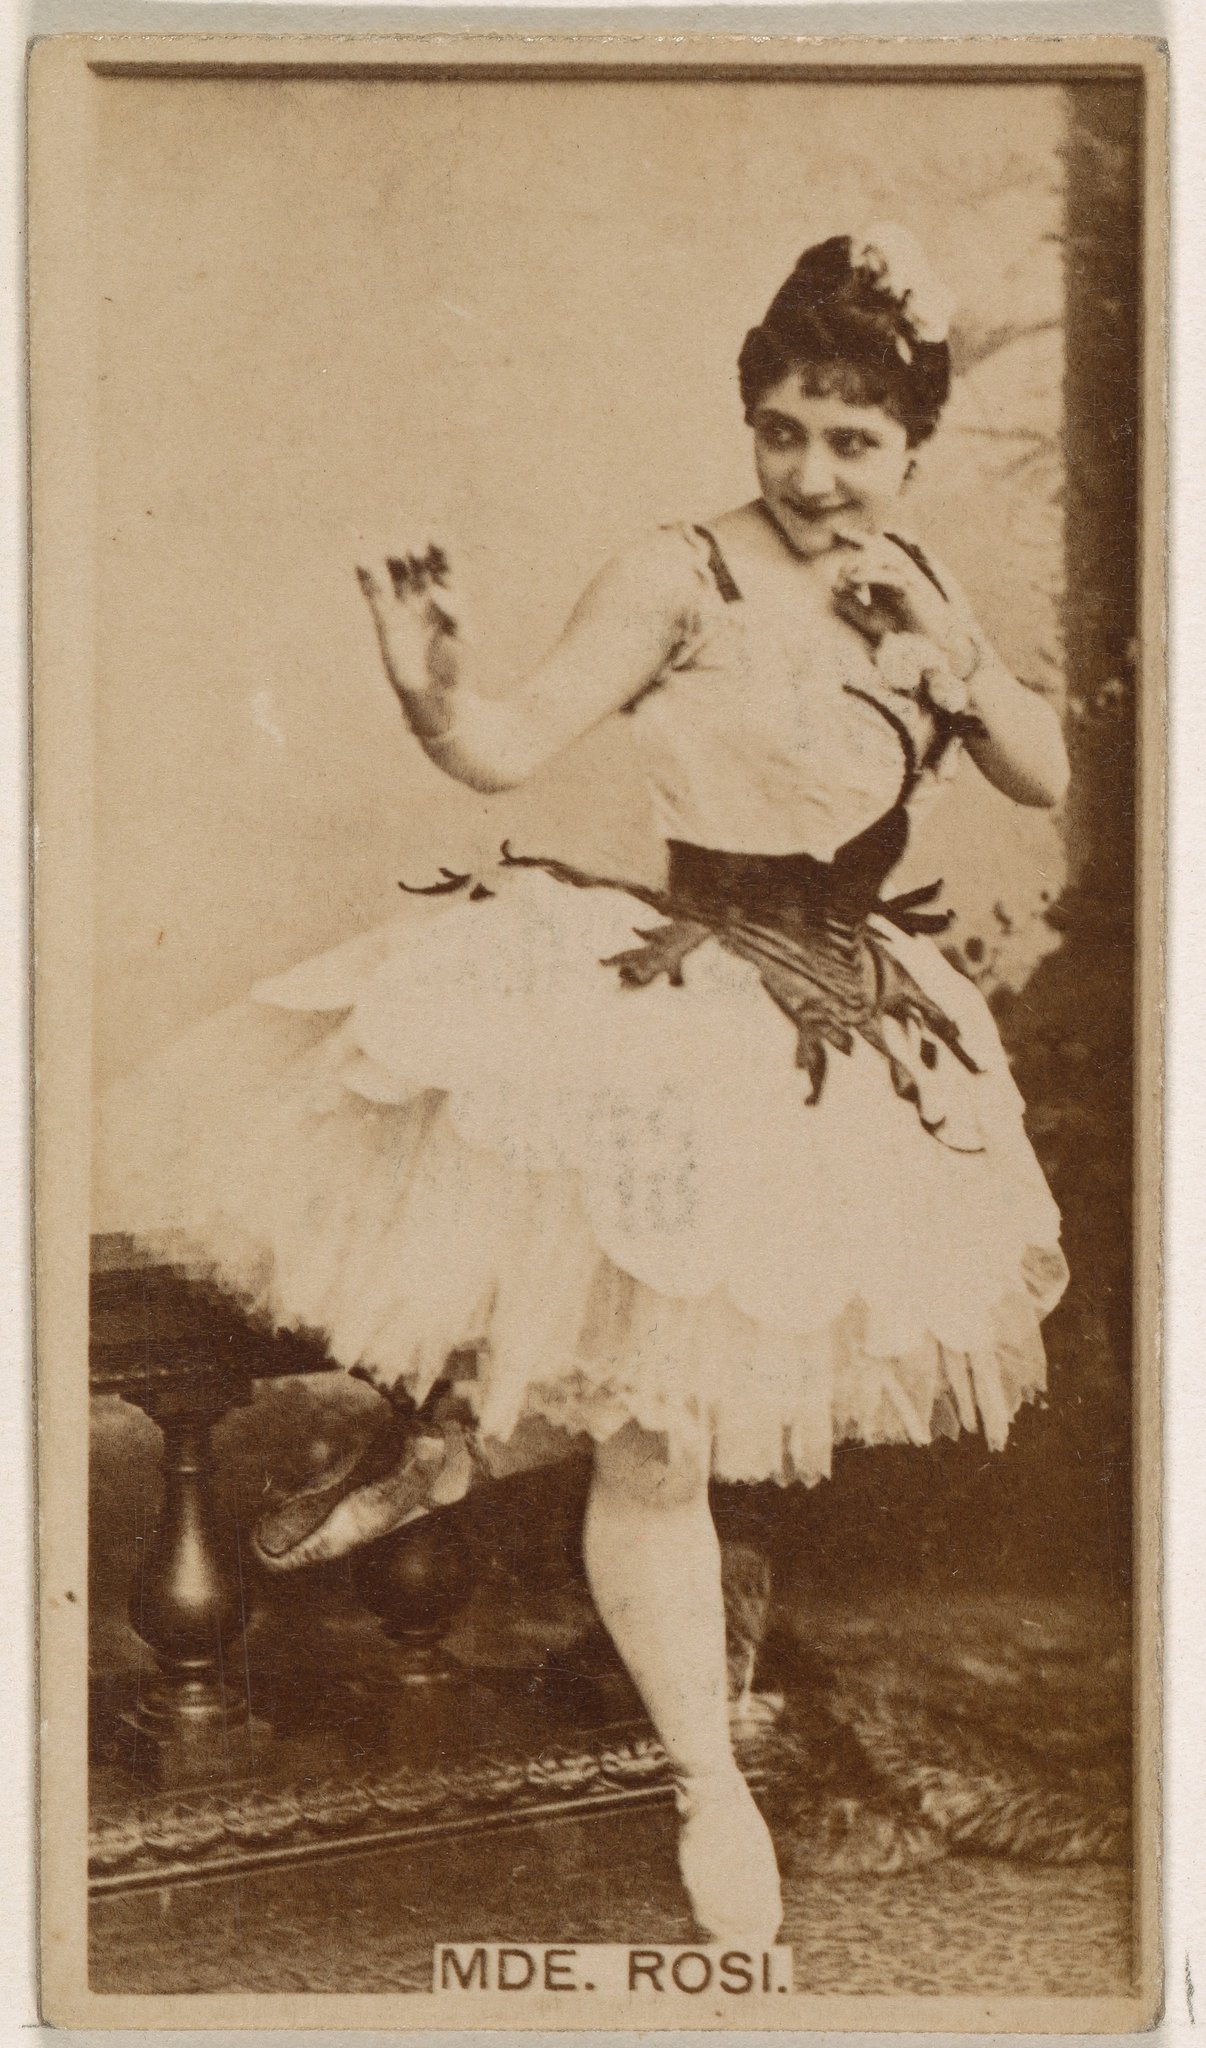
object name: photograph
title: Mde. Rosi, from the Actresses series (N245) issued by Kinney Brothers to promote Sweet Caporal Cigarettes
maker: kinney brothers tobacco company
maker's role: publisher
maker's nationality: american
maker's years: 1869-2011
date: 1890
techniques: albumen silver print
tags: portraits,women,actresses